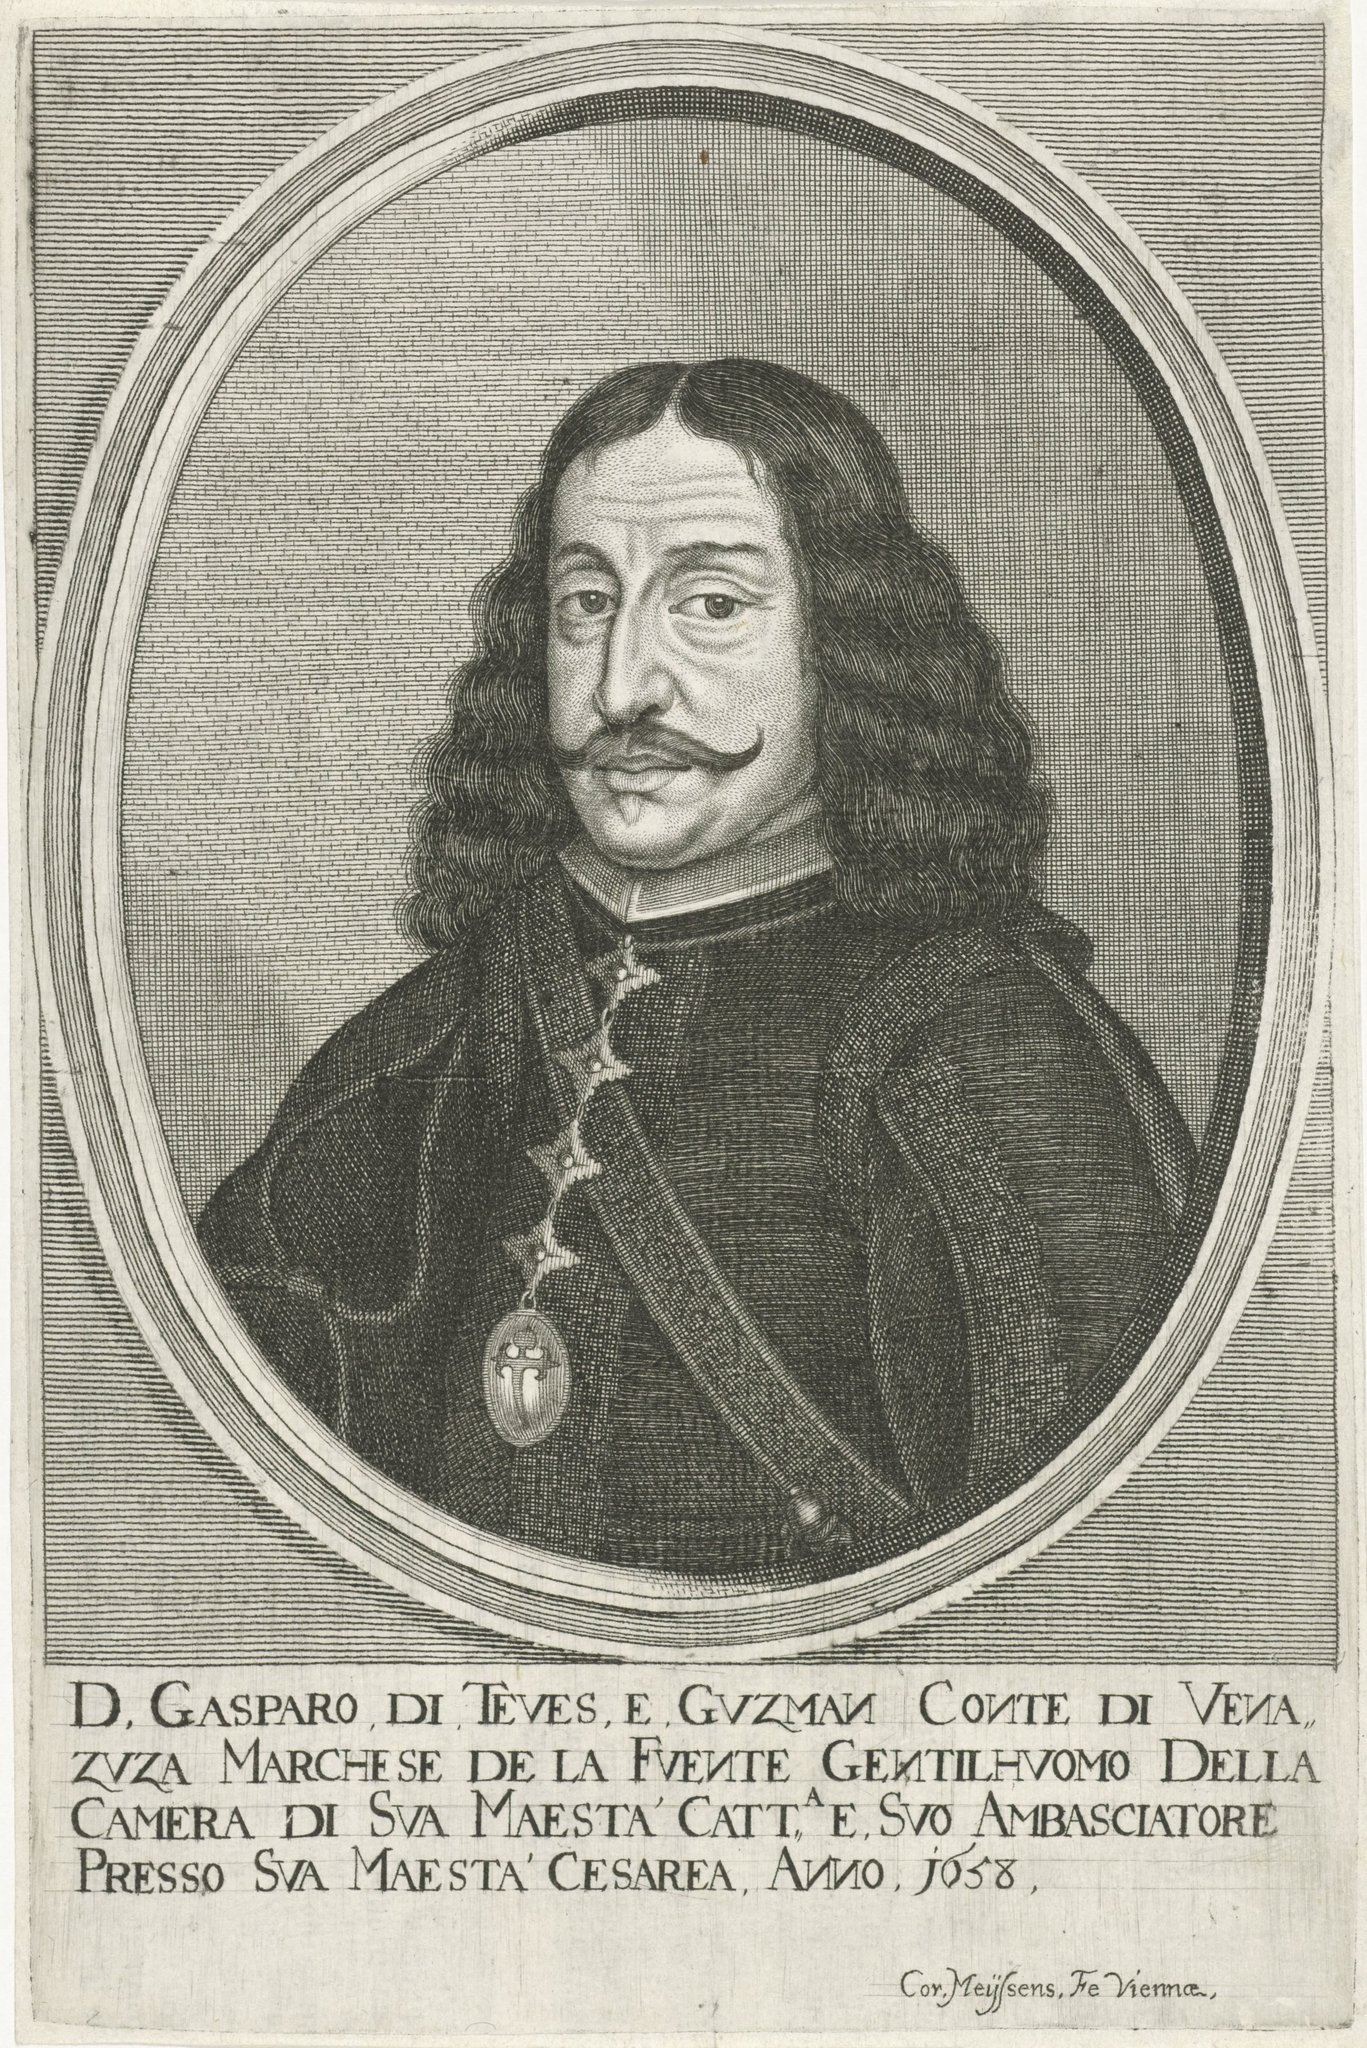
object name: book illustration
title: Portret van Don Gaspar de Tebes y Tello de Guzmán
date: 1670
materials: paper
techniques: engraving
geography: vienna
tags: don gaspar de tebes y tello de guzmán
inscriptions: collector's mark: Lugt 2228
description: Prent gebruikt in: Gualdo Priorato, Galeazzo. Historia di Leopoldo Cesare, (...). 3 dln. Wenen, Giovanni Battista Hacque, 1670-1674, dl. 1.